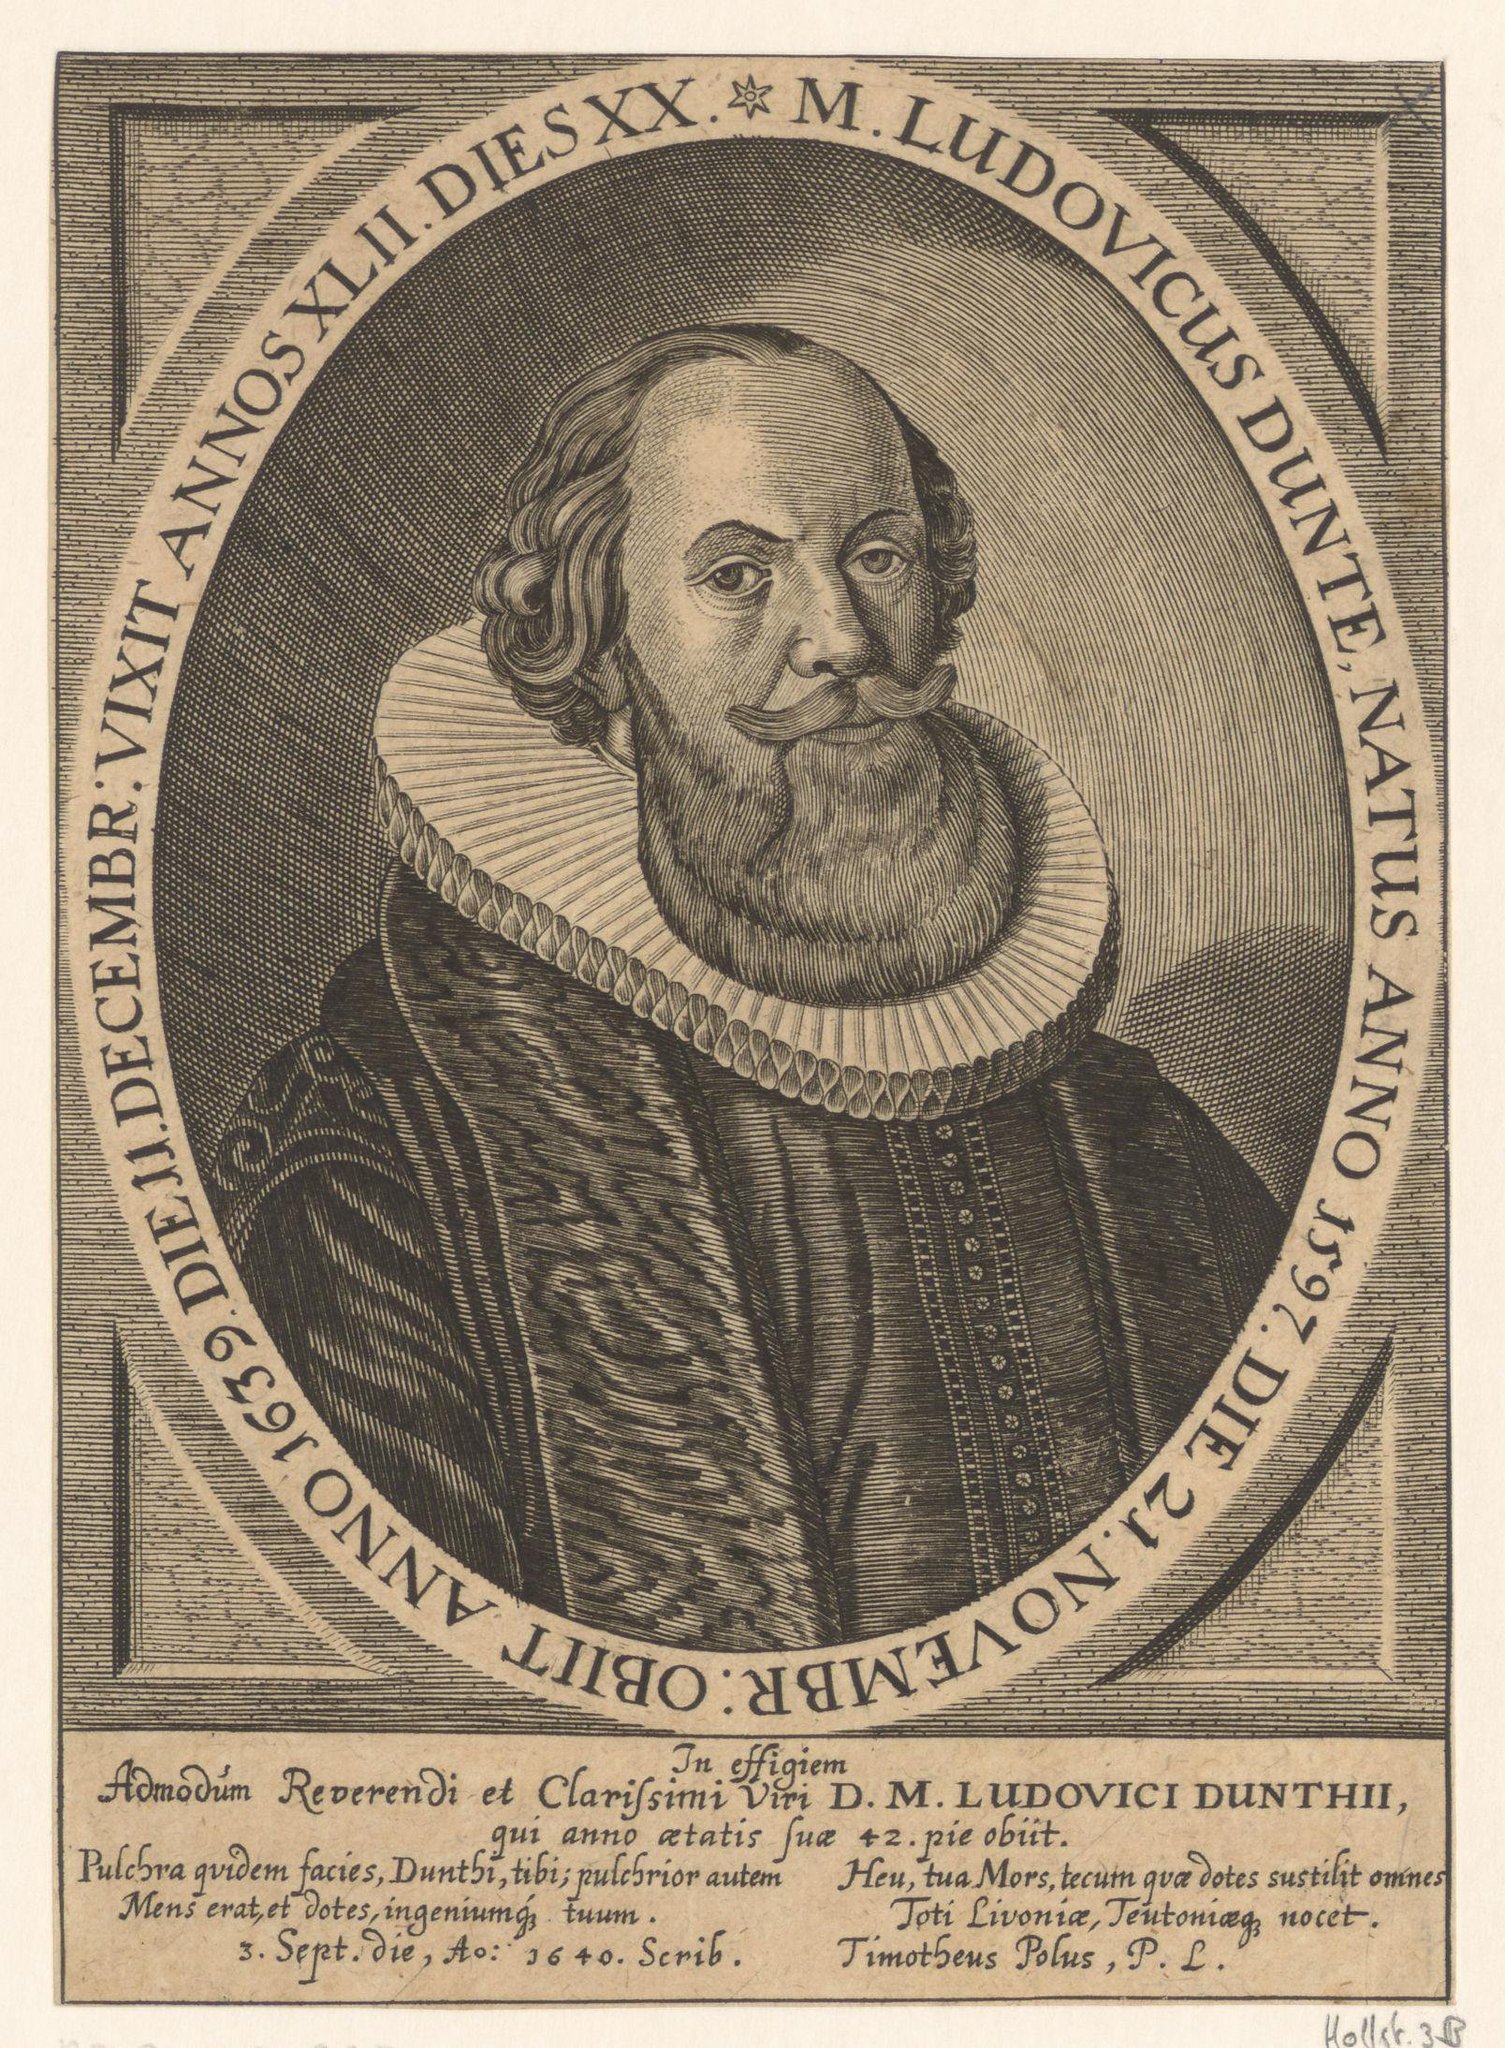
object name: print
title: Portret van Ludovicus Dunte op 42-jarige leeftijd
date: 1640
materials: paper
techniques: engraving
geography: hamburg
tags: clergyman, theologian, historical persons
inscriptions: collector's mark: Lugt 2228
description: Tekst in het Latijn in de omlijsting en in de ondermarge.